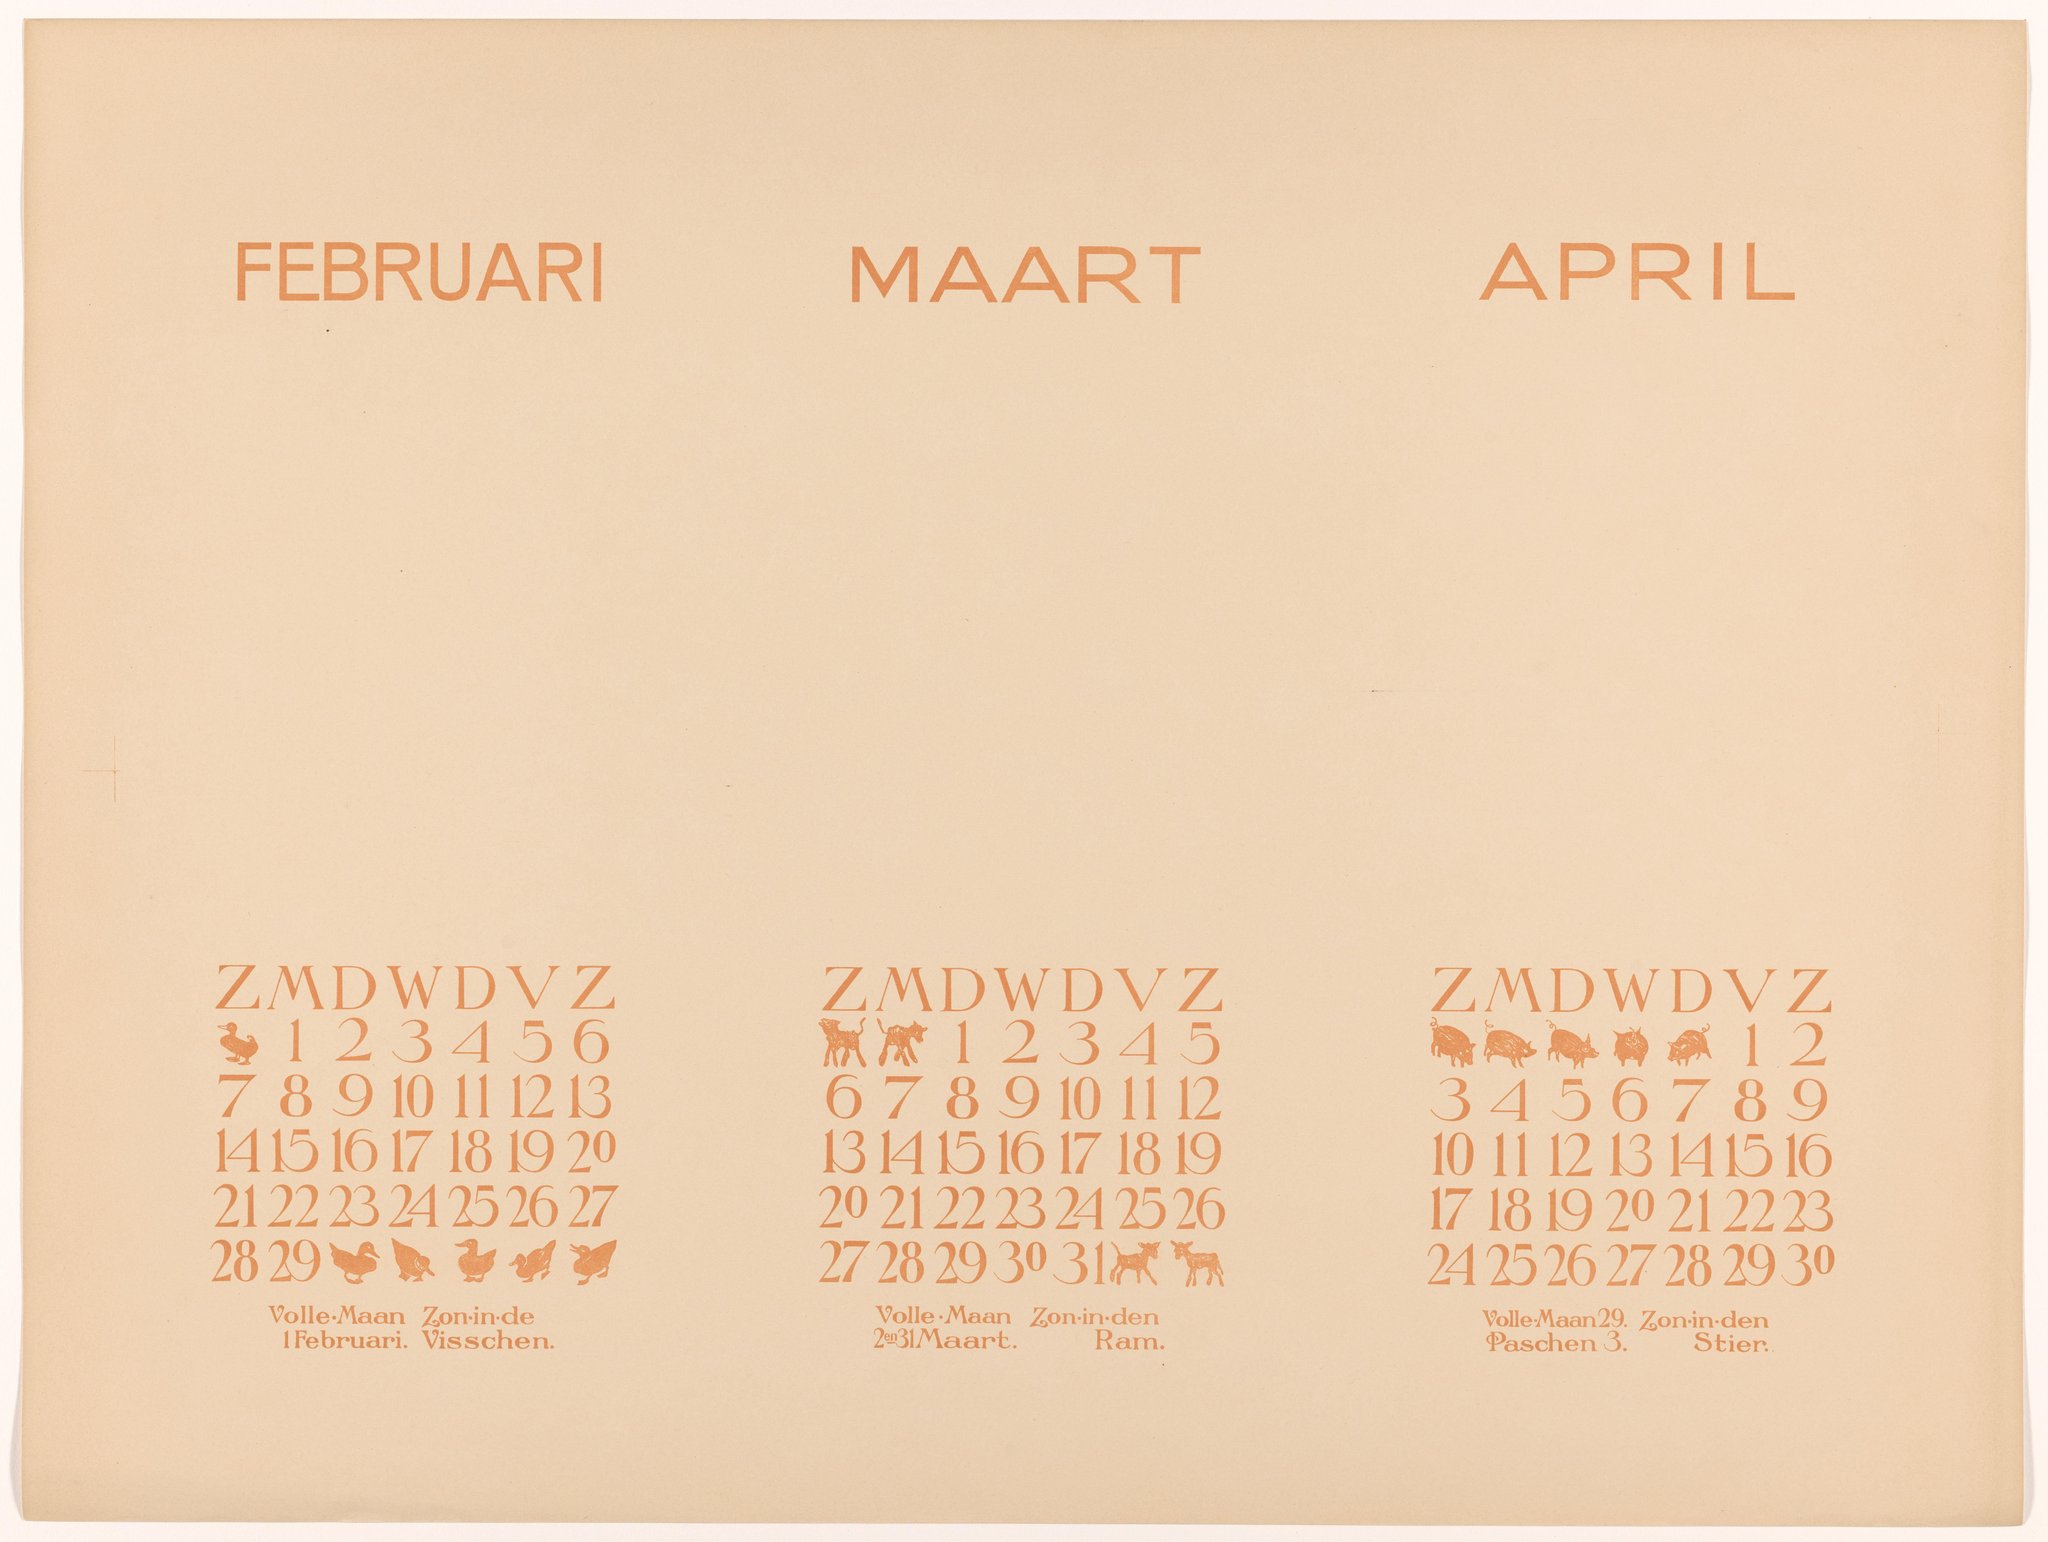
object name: print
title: Kalenders voor februari, maart en april 1904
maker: theo van hoytema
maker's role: draughtsman, painter, print maker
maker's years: 1863-1917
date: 1904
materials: paper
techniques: lithograph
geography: amsterdam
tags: calendar, almanac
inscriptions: collector's mark: Lugt 2233